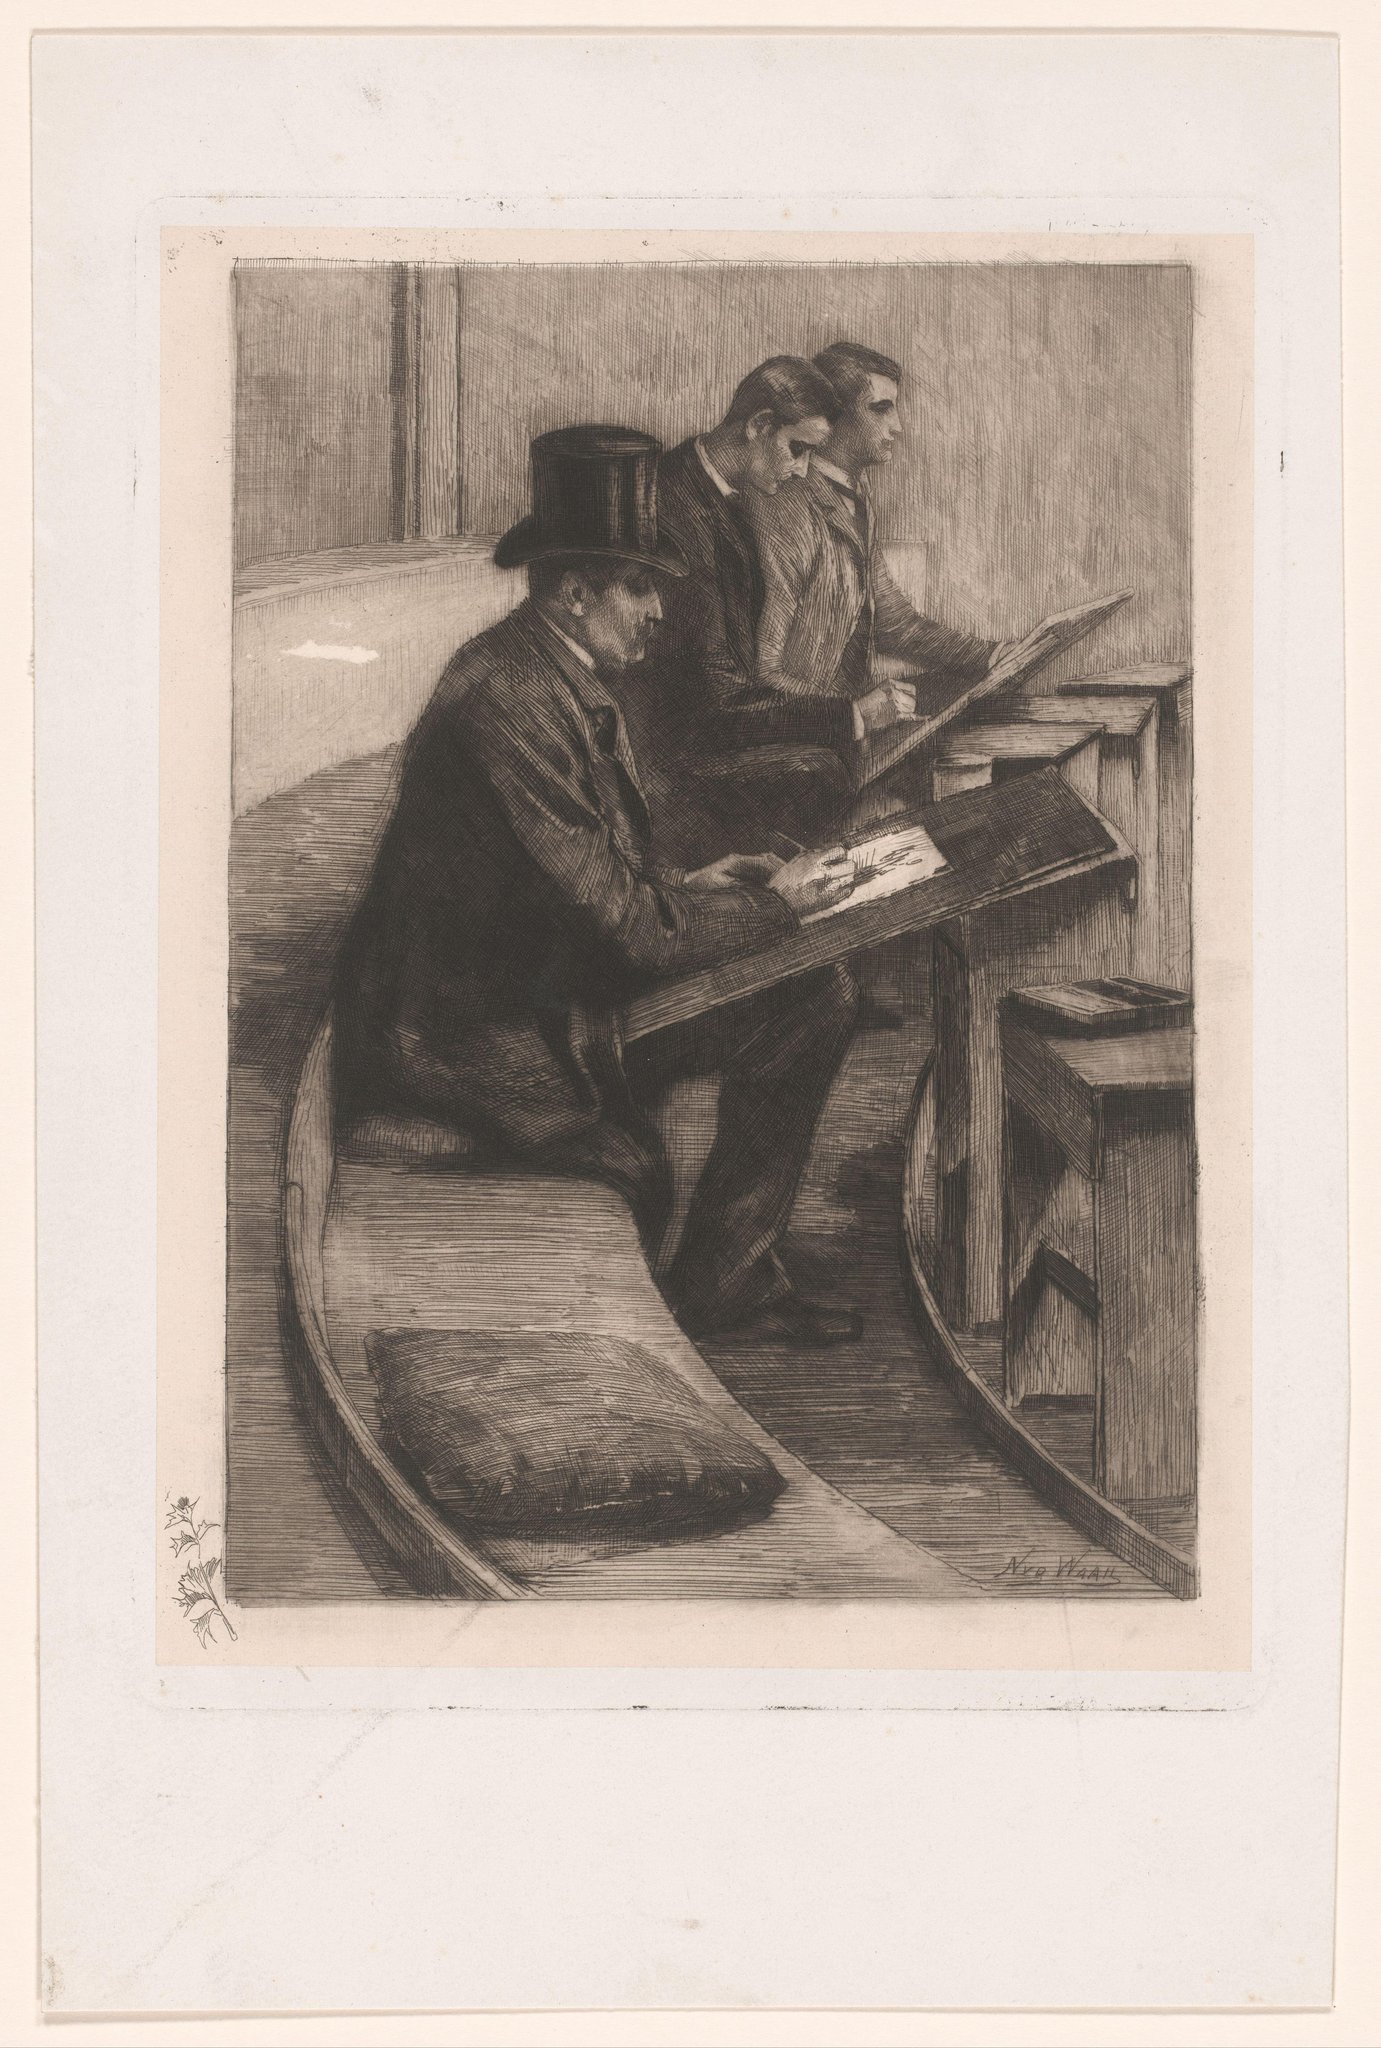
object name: print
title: In Felix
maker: nicolaas van der waay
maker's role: draughtsman, painter, print maker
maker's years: 1855-1936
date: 1865-1936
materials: paper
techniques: drypoint, etching, intaglio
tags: drawing-lesson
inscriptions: collector's mark: Lugt 2760, collector's mark: Lugt 2228